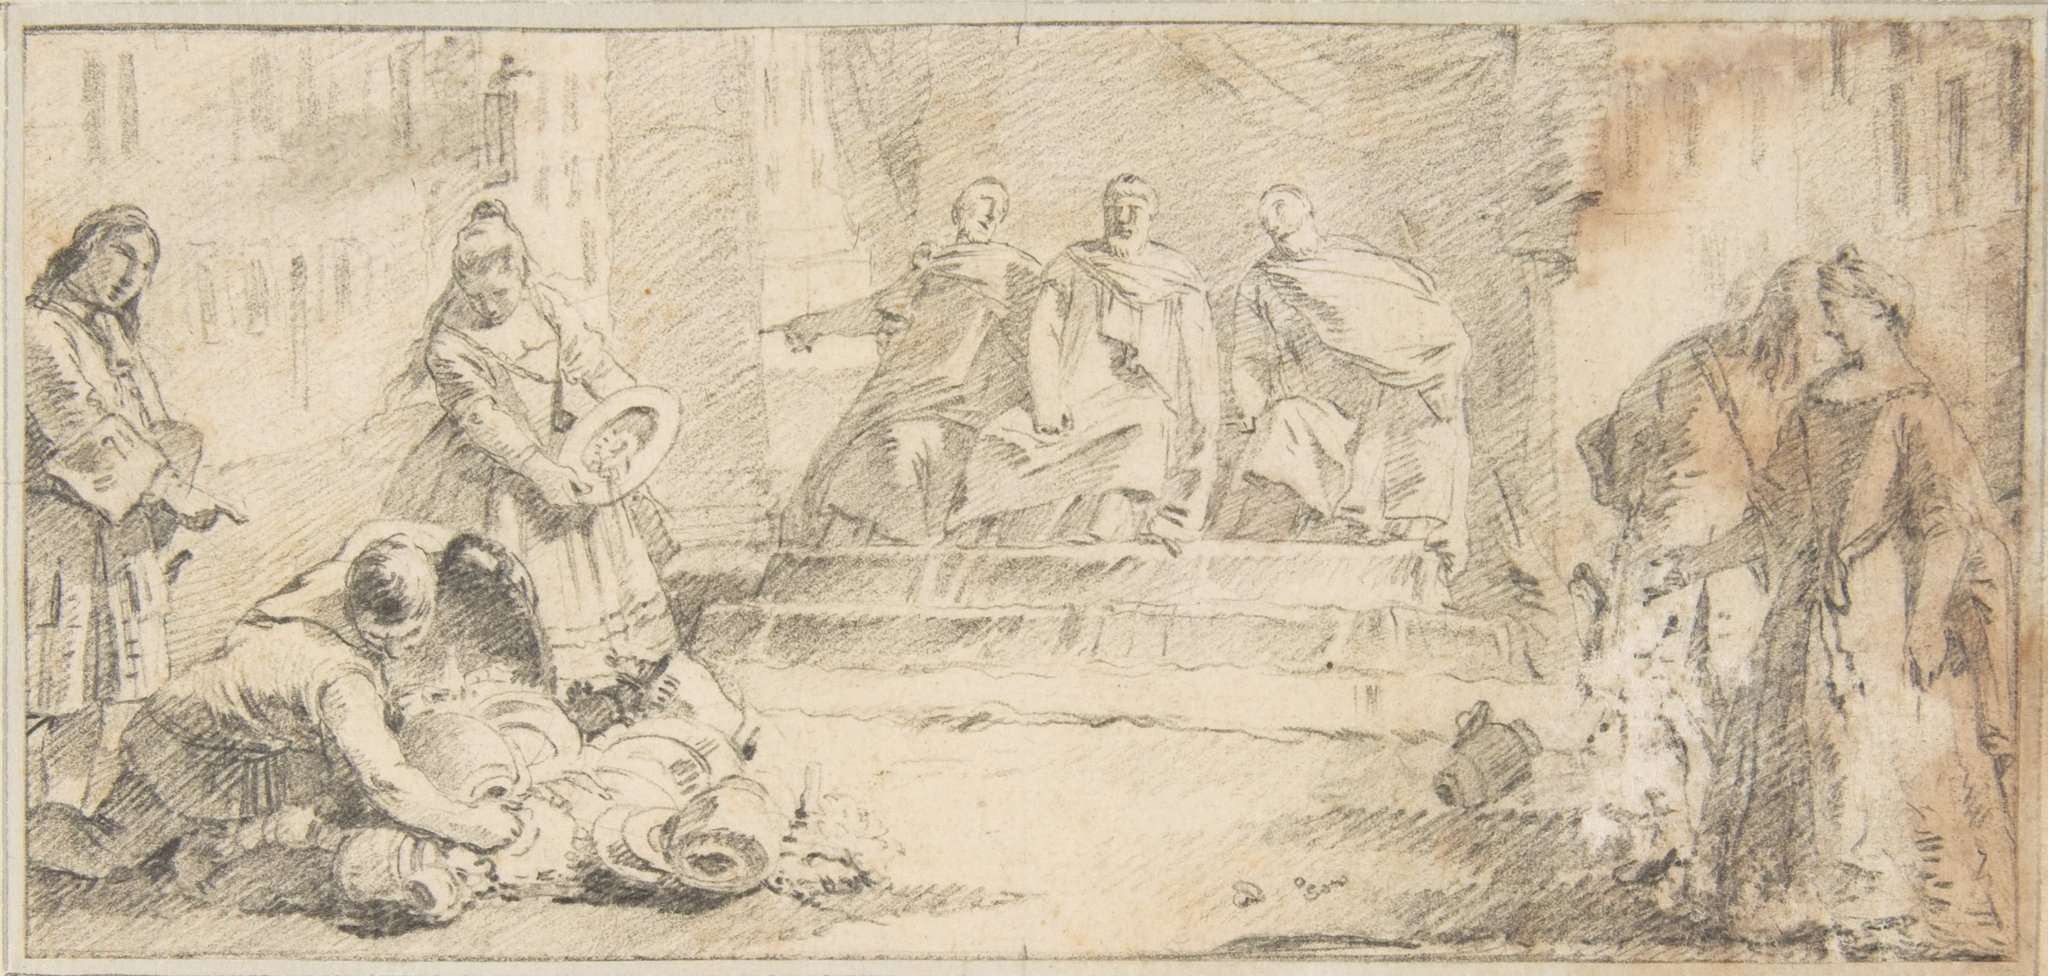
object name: drawing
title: Illustration for a Book: Booty Presented to Three Dignitaries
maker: giovanni battista tiepolo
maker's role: artist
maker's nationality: italian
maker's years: 1696-1770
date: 1696-1770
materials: chalk, graphite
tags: men,women,working